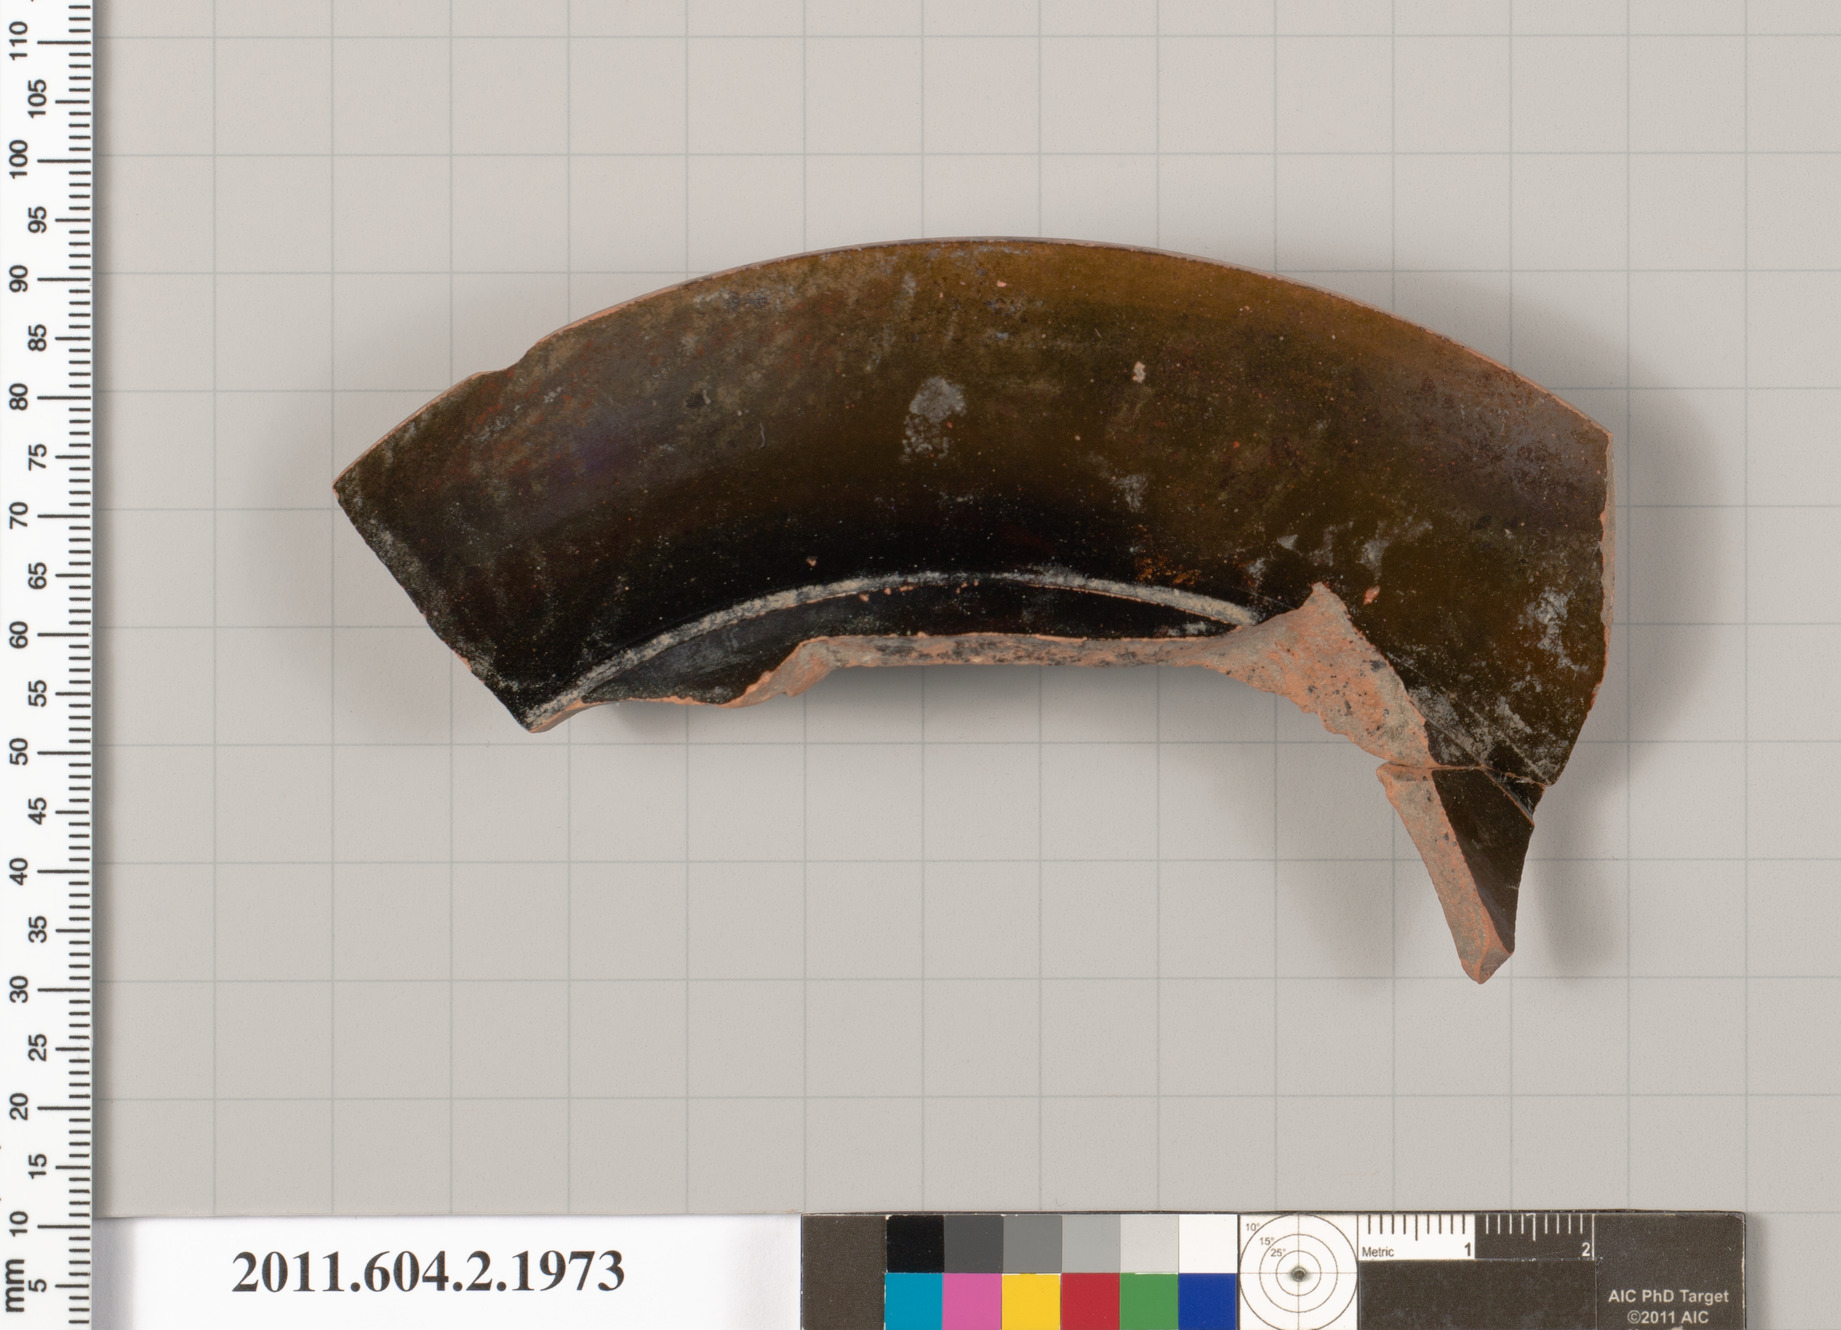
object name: neck amphora fragment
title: Terracotta fragment of a Nolan neck-amphora (jar)?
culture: greek, attic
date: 475-451 BCE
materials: terracotta